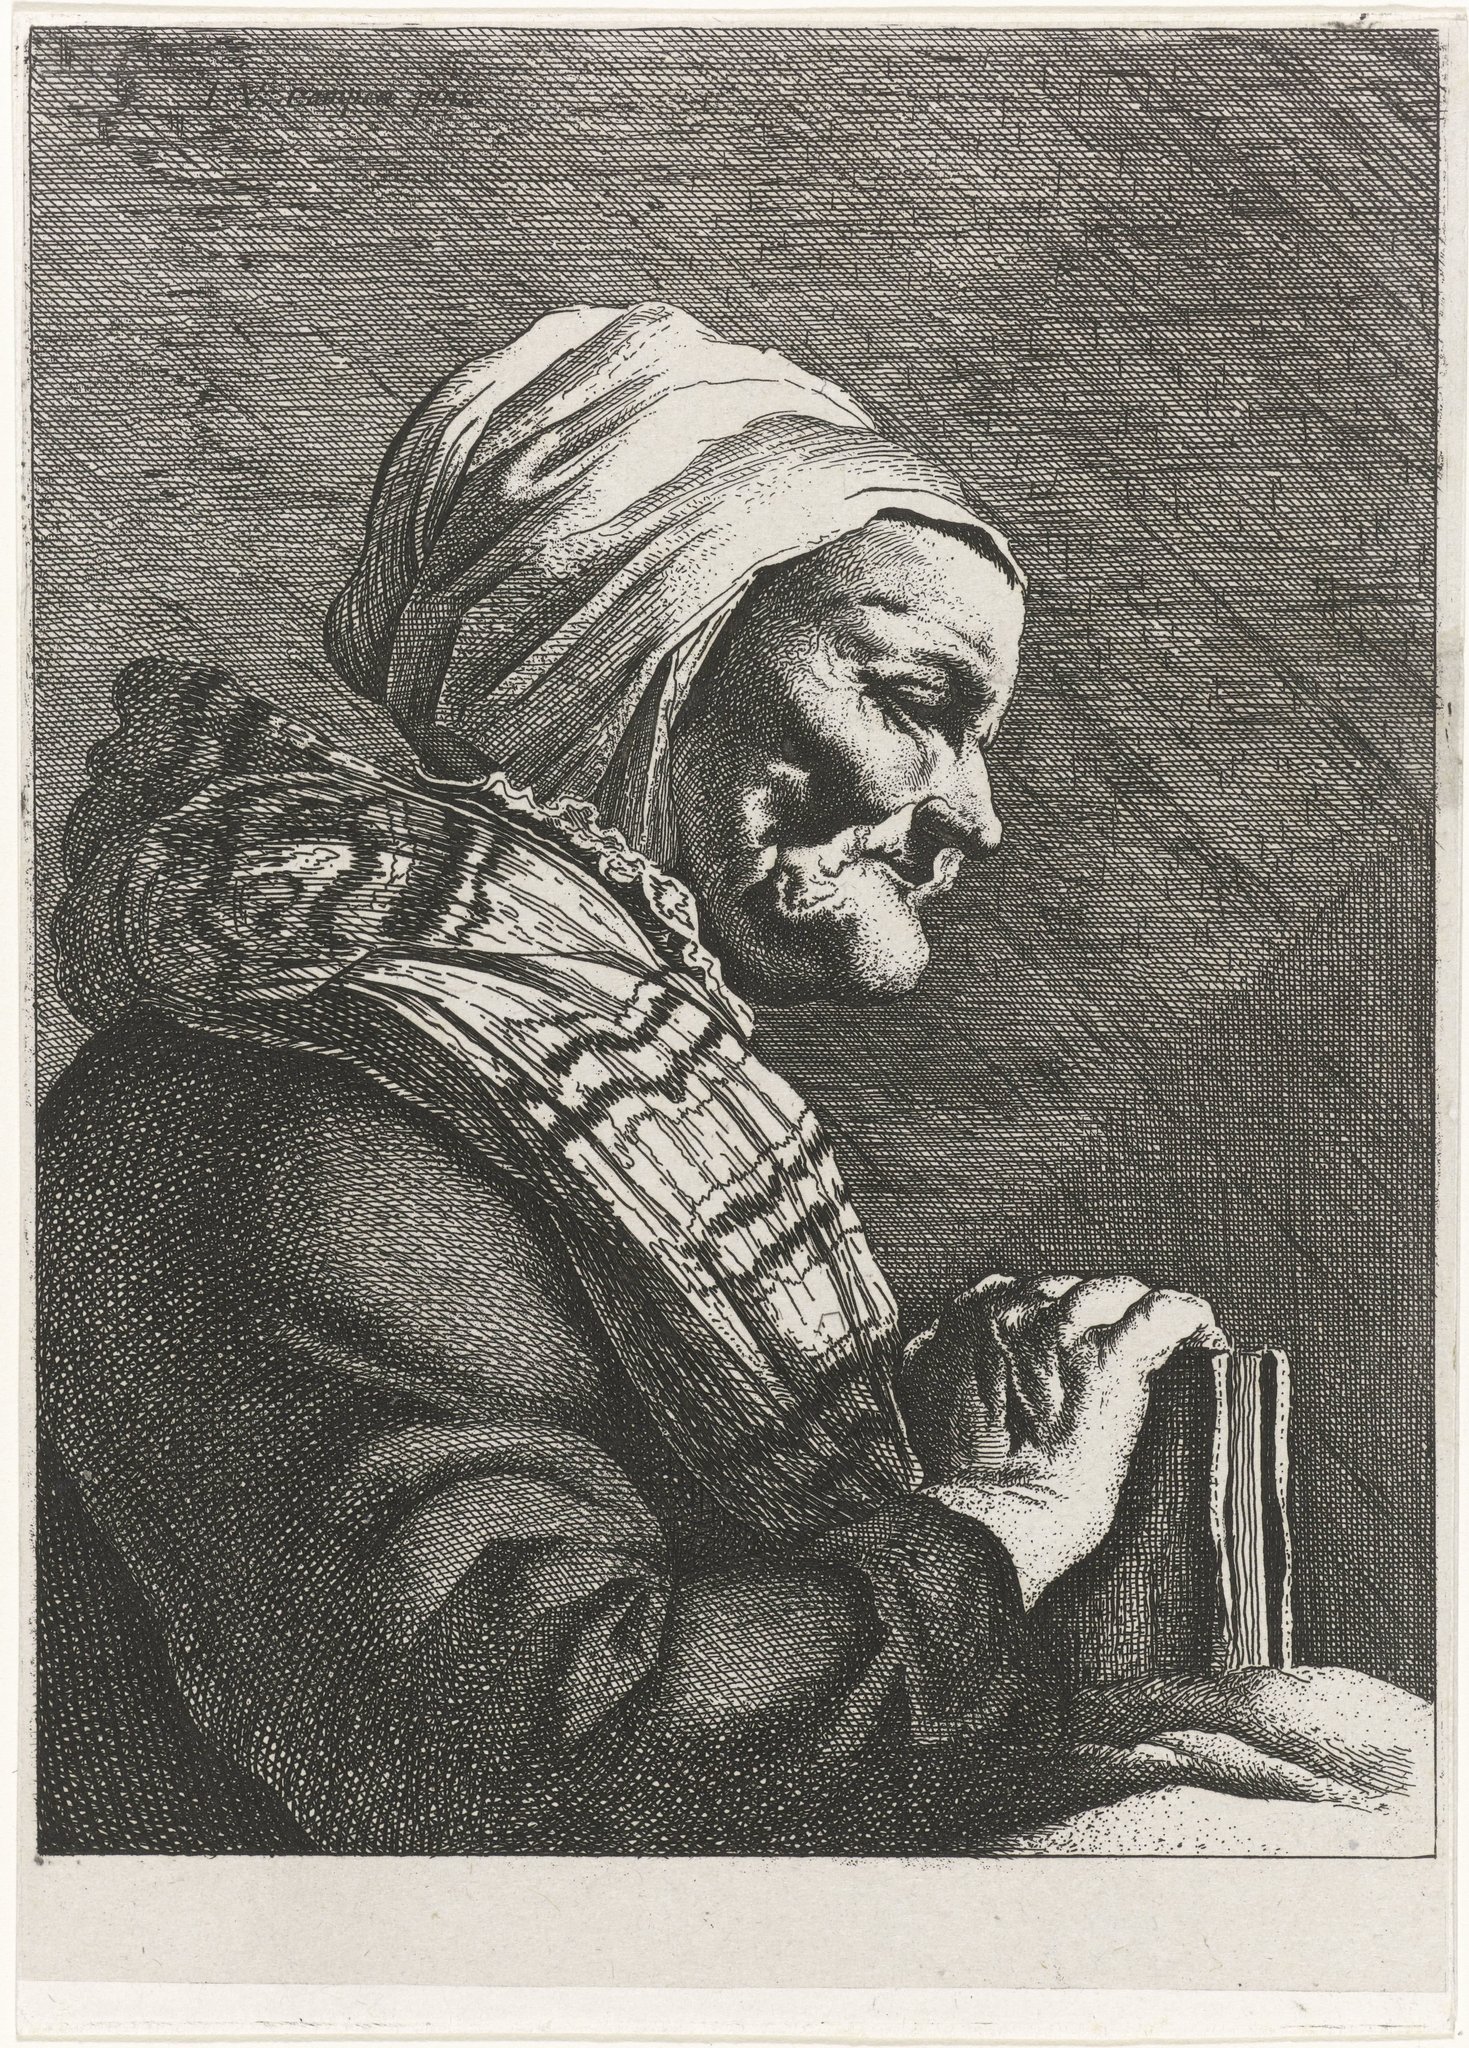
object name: print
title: Oude vrouw met boek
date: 1828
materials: paper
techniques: etching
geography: london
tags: old woman, book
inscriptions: collector's mark: Lugt 2228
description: Prent 12 uit: Ottley, William Young. A collection of thirty-nine facsimiles, rare etchings, by celebrated painters of the Italian, Dutch and Flemish schools. Londen: 1828.